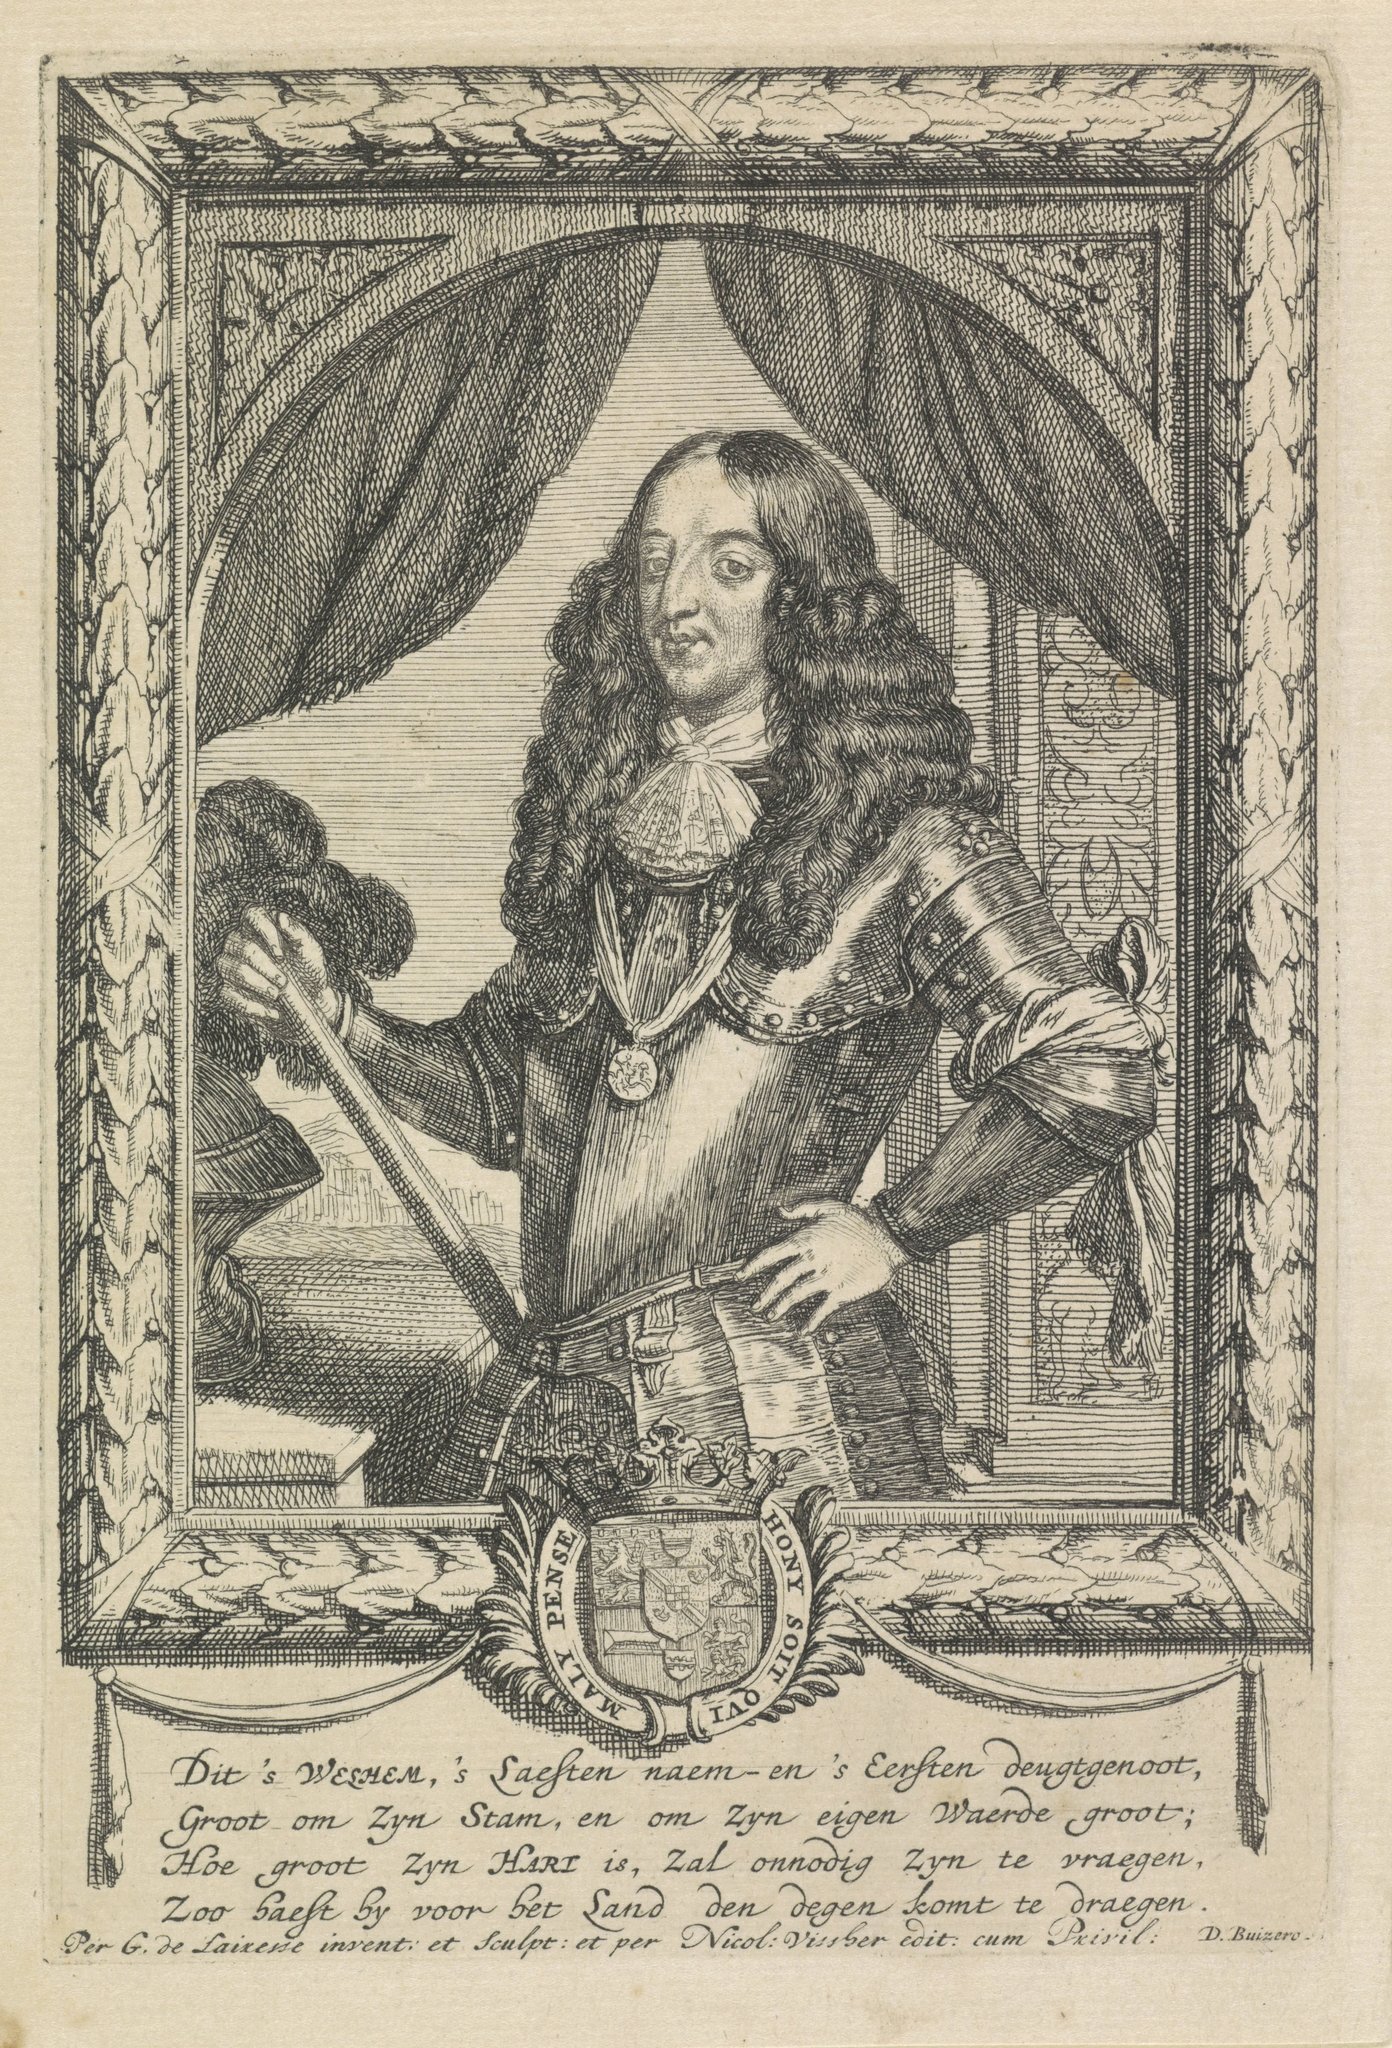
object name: print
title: Portret van Willem III, prins van Oranje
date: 1670-1709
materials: paper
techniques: engraving, etching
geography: amsterdam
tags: the hague, william iii (prince of orange and king of england, scotland, and ireland), knighthood order (garter) - insignia of a knighthood order, e.g.: badge, chain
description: Portret van Willem III in een rechthoek van lauwerbladen. Midden onder zijn wapen met een kroon, gedecoreerd met de Kousenband en het devies van de Orde van de Kousenband. In de ondermarge vier regels Nederlandse tekst.